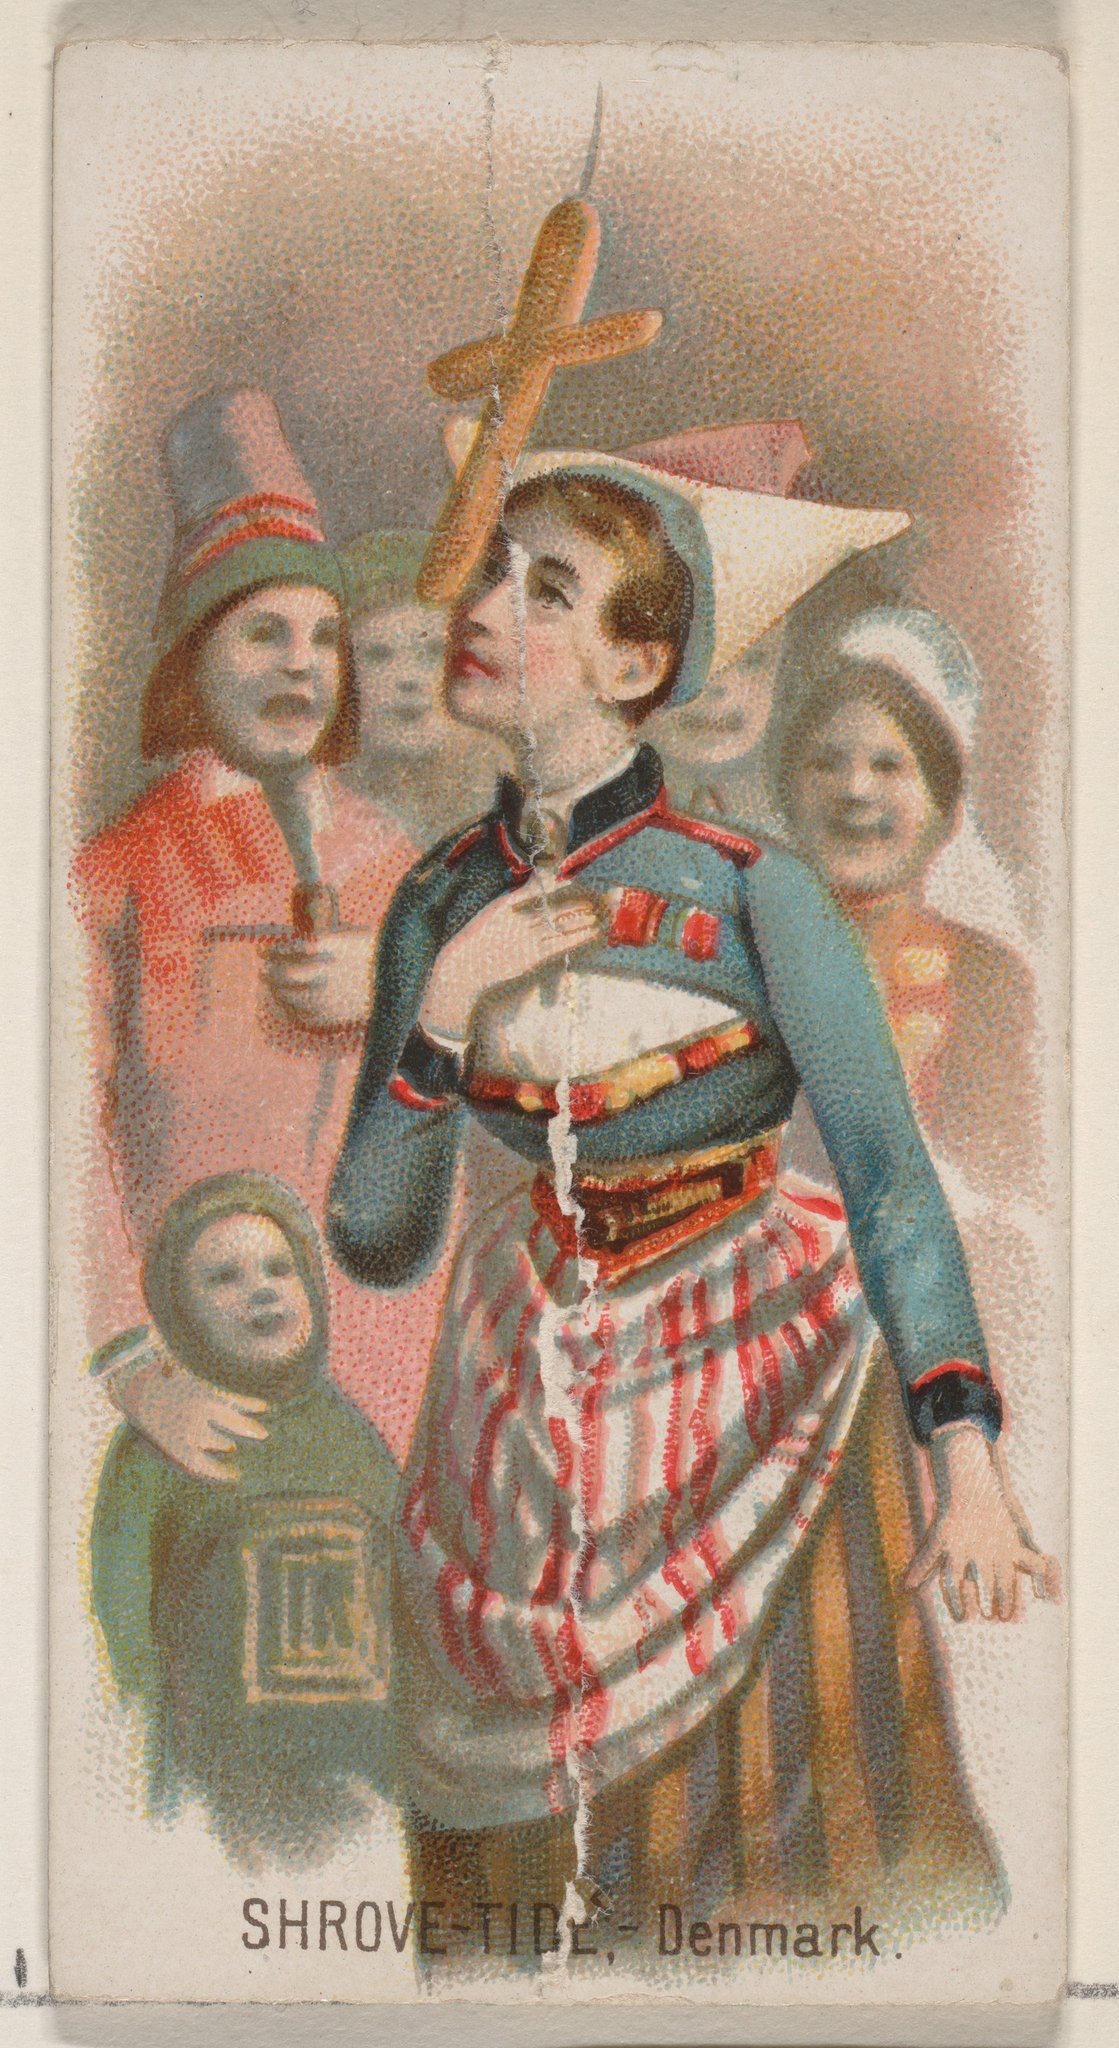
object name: print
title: Shrove-Tide, Denmark, from the Holidays series (N80) for Duke brand cigarettes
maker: w. duke, sons & co.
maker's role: publisher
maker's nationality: american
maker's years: 1870-1920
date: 1890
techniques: color lithograph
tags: women